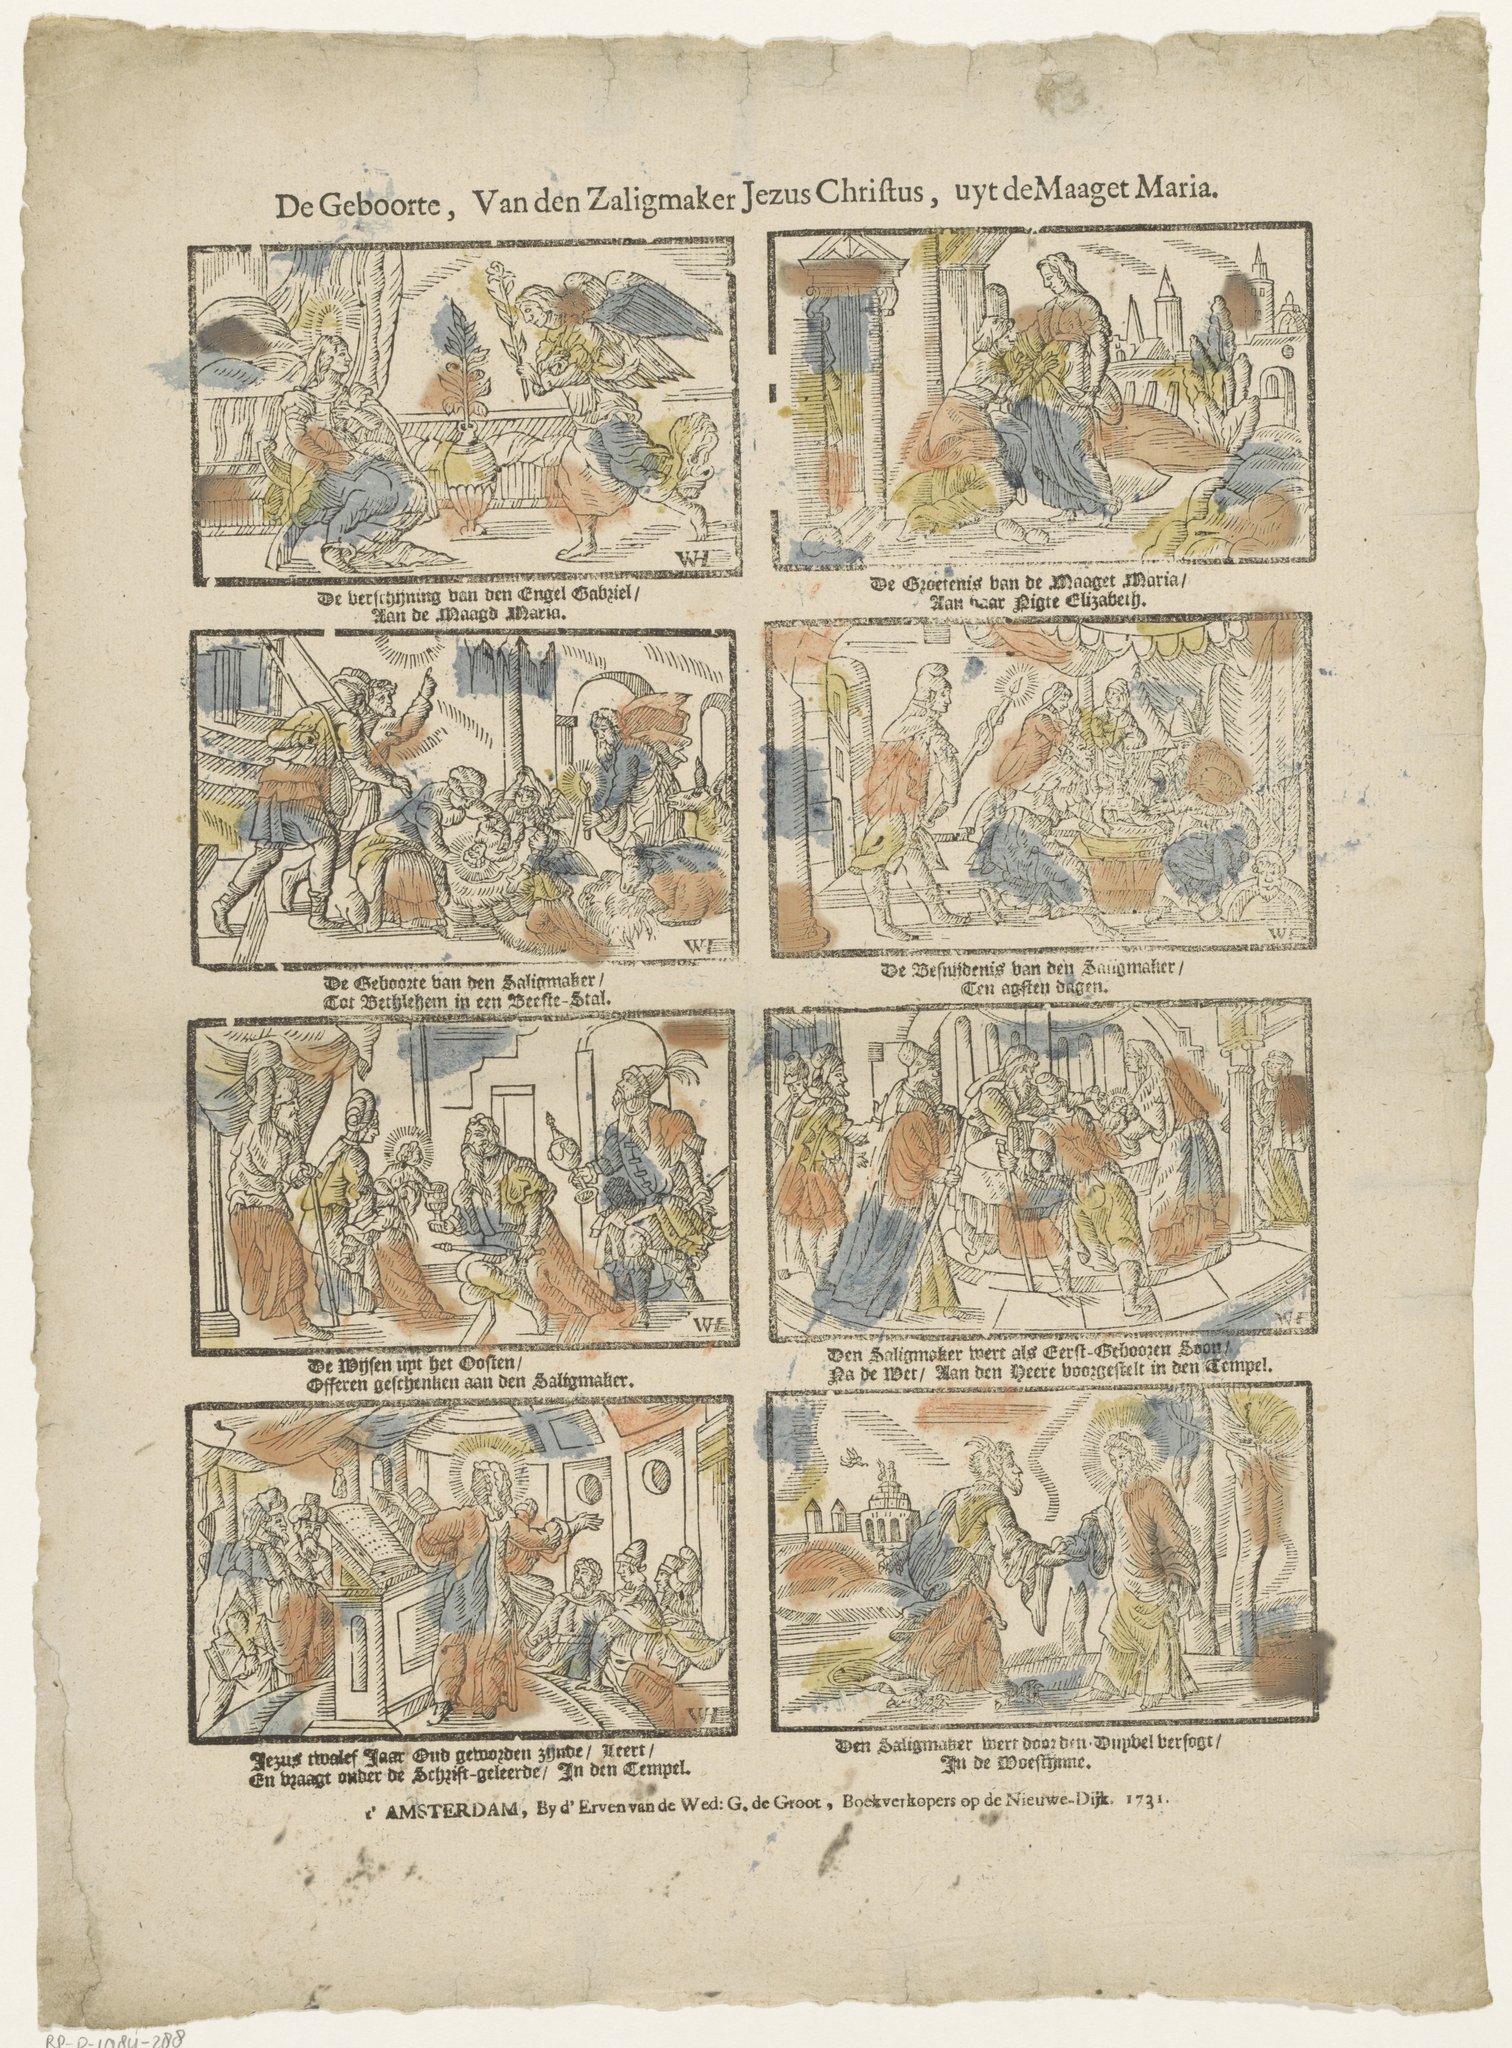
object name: print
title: De geboorte, van den zaligmaker Jezus Christus, uyt de Maaget Maria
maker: monogrammist wh (prentmaker)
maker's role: print maker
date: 1731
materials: paper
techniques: colour, letterpress printing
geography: amsterdam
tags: birth and youth of christ, the annunciation: mary sitting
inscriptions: collector's mark: Lugt 2760, collector's mark: Lugt 2228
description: Blad met 8 voorstellingen uit het leven van Christus, zoals de Annunciatie, de geboorte en de besnijdenis. Onder elke afbeelding een tweeregelig vers.